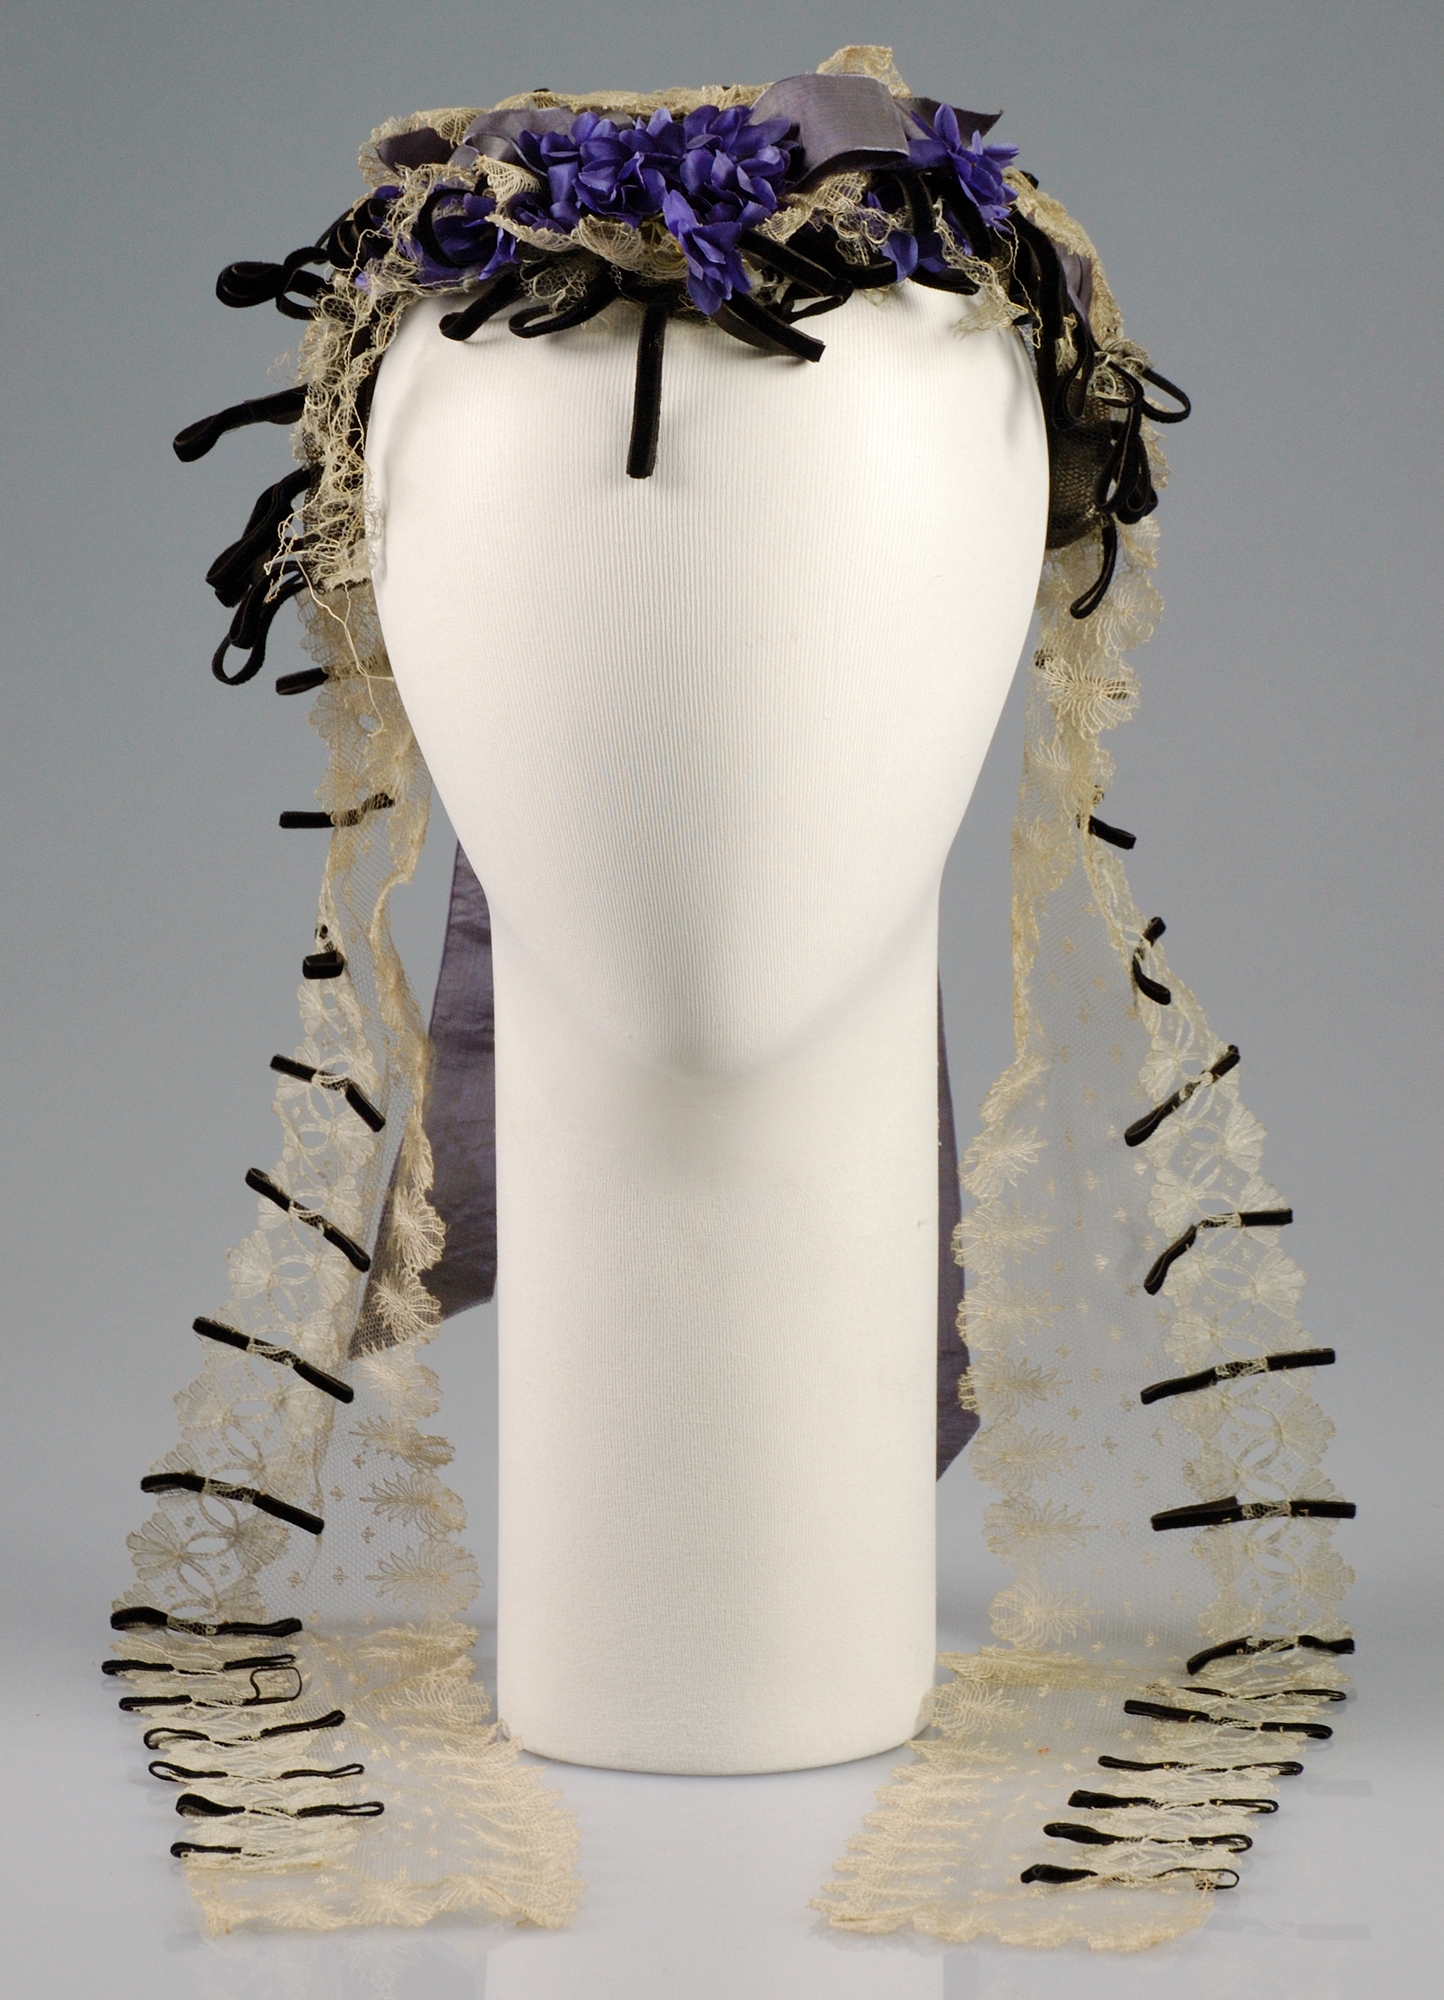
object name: cap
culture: american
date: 1860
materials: silk